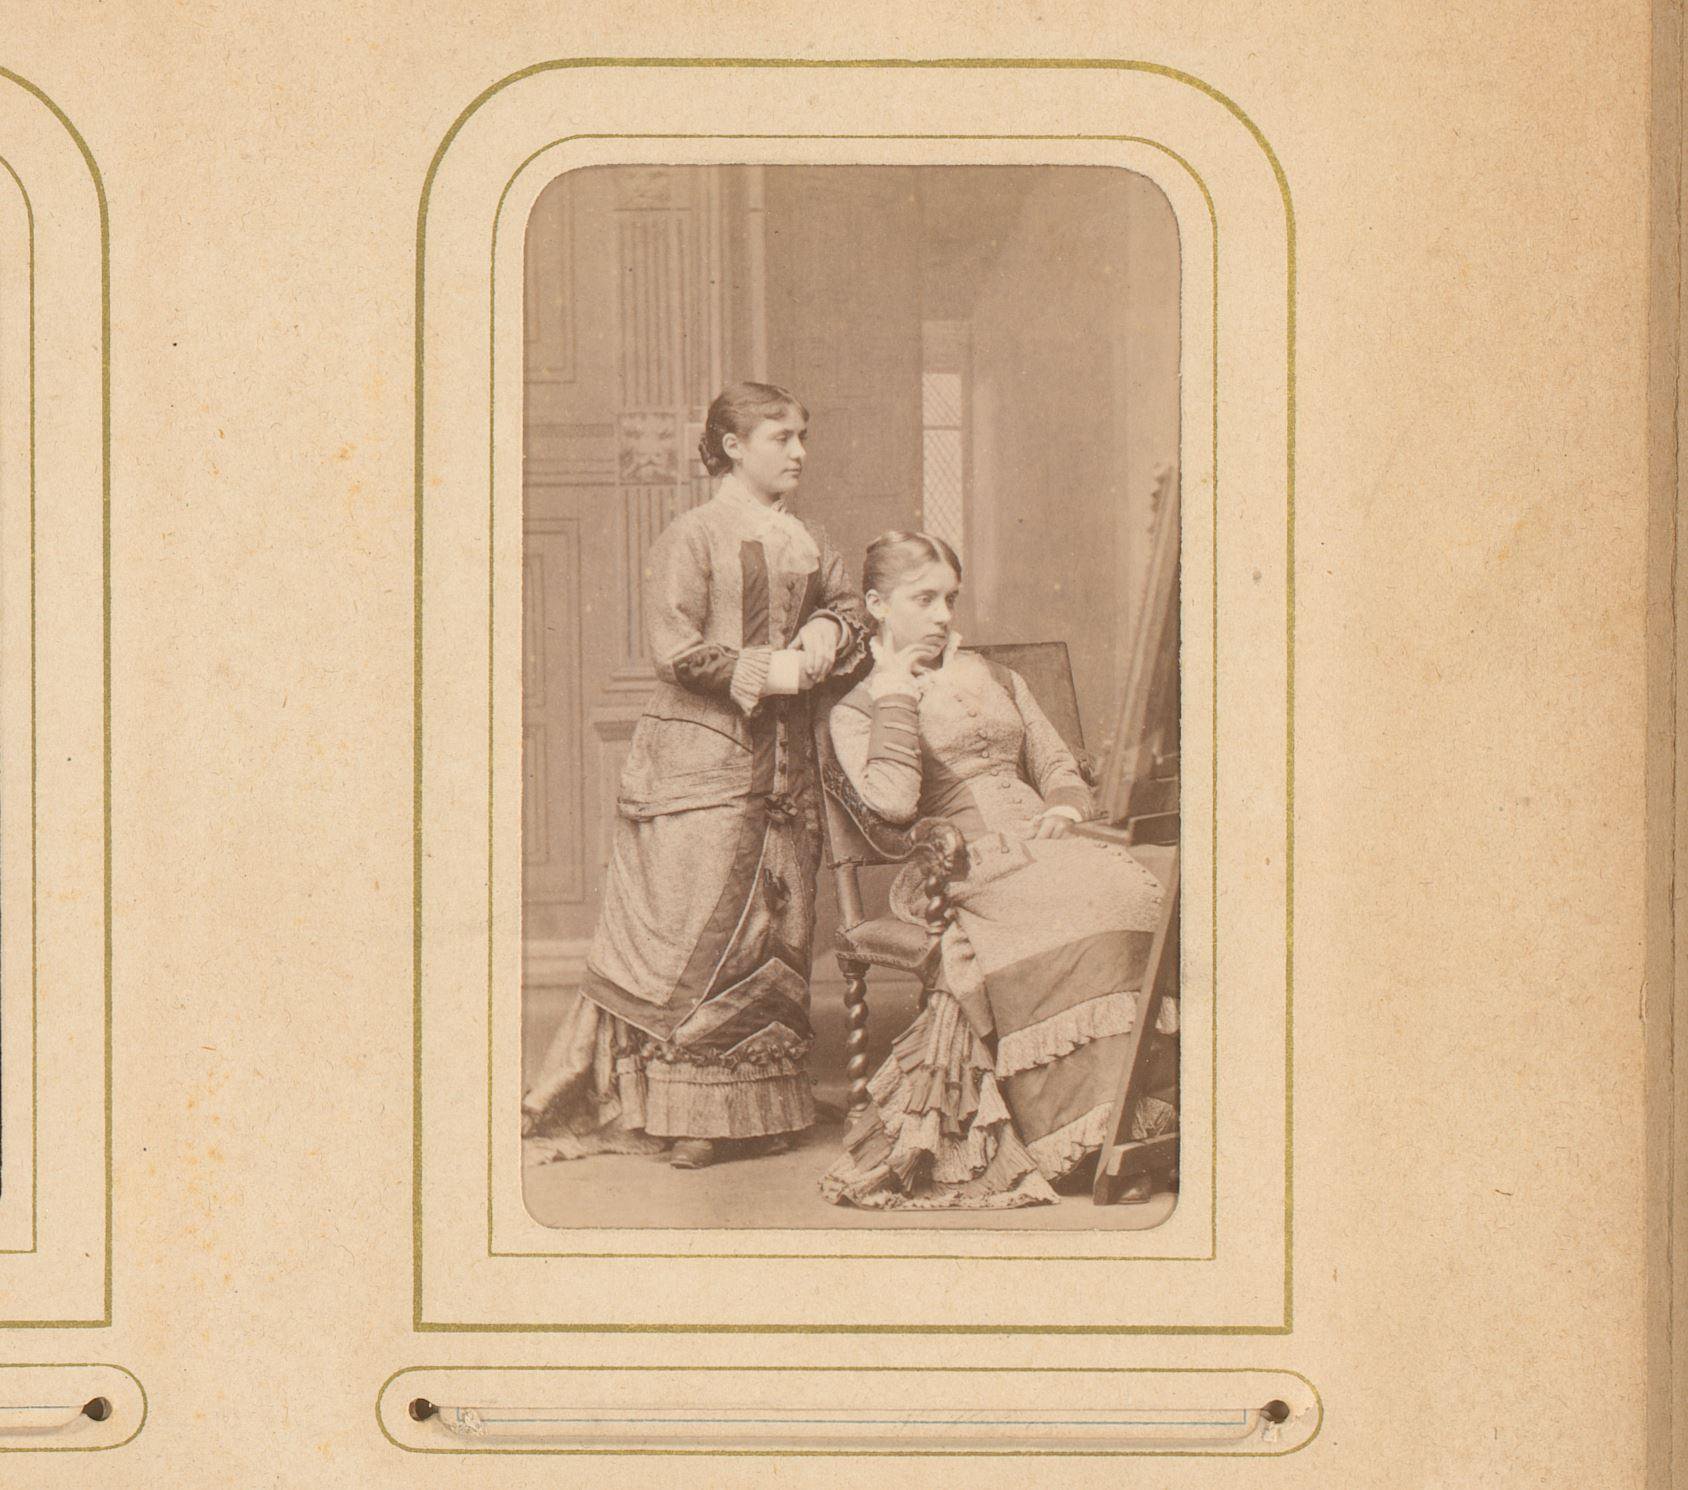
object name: album leaf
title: Portret van twee vrouwen voor een schildersezel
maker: johannes gerardus kramer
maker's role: fotograaf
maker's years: 1845-1903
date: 1878-1903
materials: cardboard, photographic support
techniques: albumen print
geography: groningen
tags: historical persons - bb - woman, adult woman (+ two persons), easel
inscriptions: inscription: ‘Bekroond met Zilver/ UTRECHT/ 1876./ VEENDAM/ 1878./ J. G. Kramer/ PHOTOGRAPHISCH ATELIER/ A KERK, H 129./ GRONINGEN./ No. .../ Het negativ blijft ter nabestelling bewaard./ Vergrootingen in alle afmetingen.’